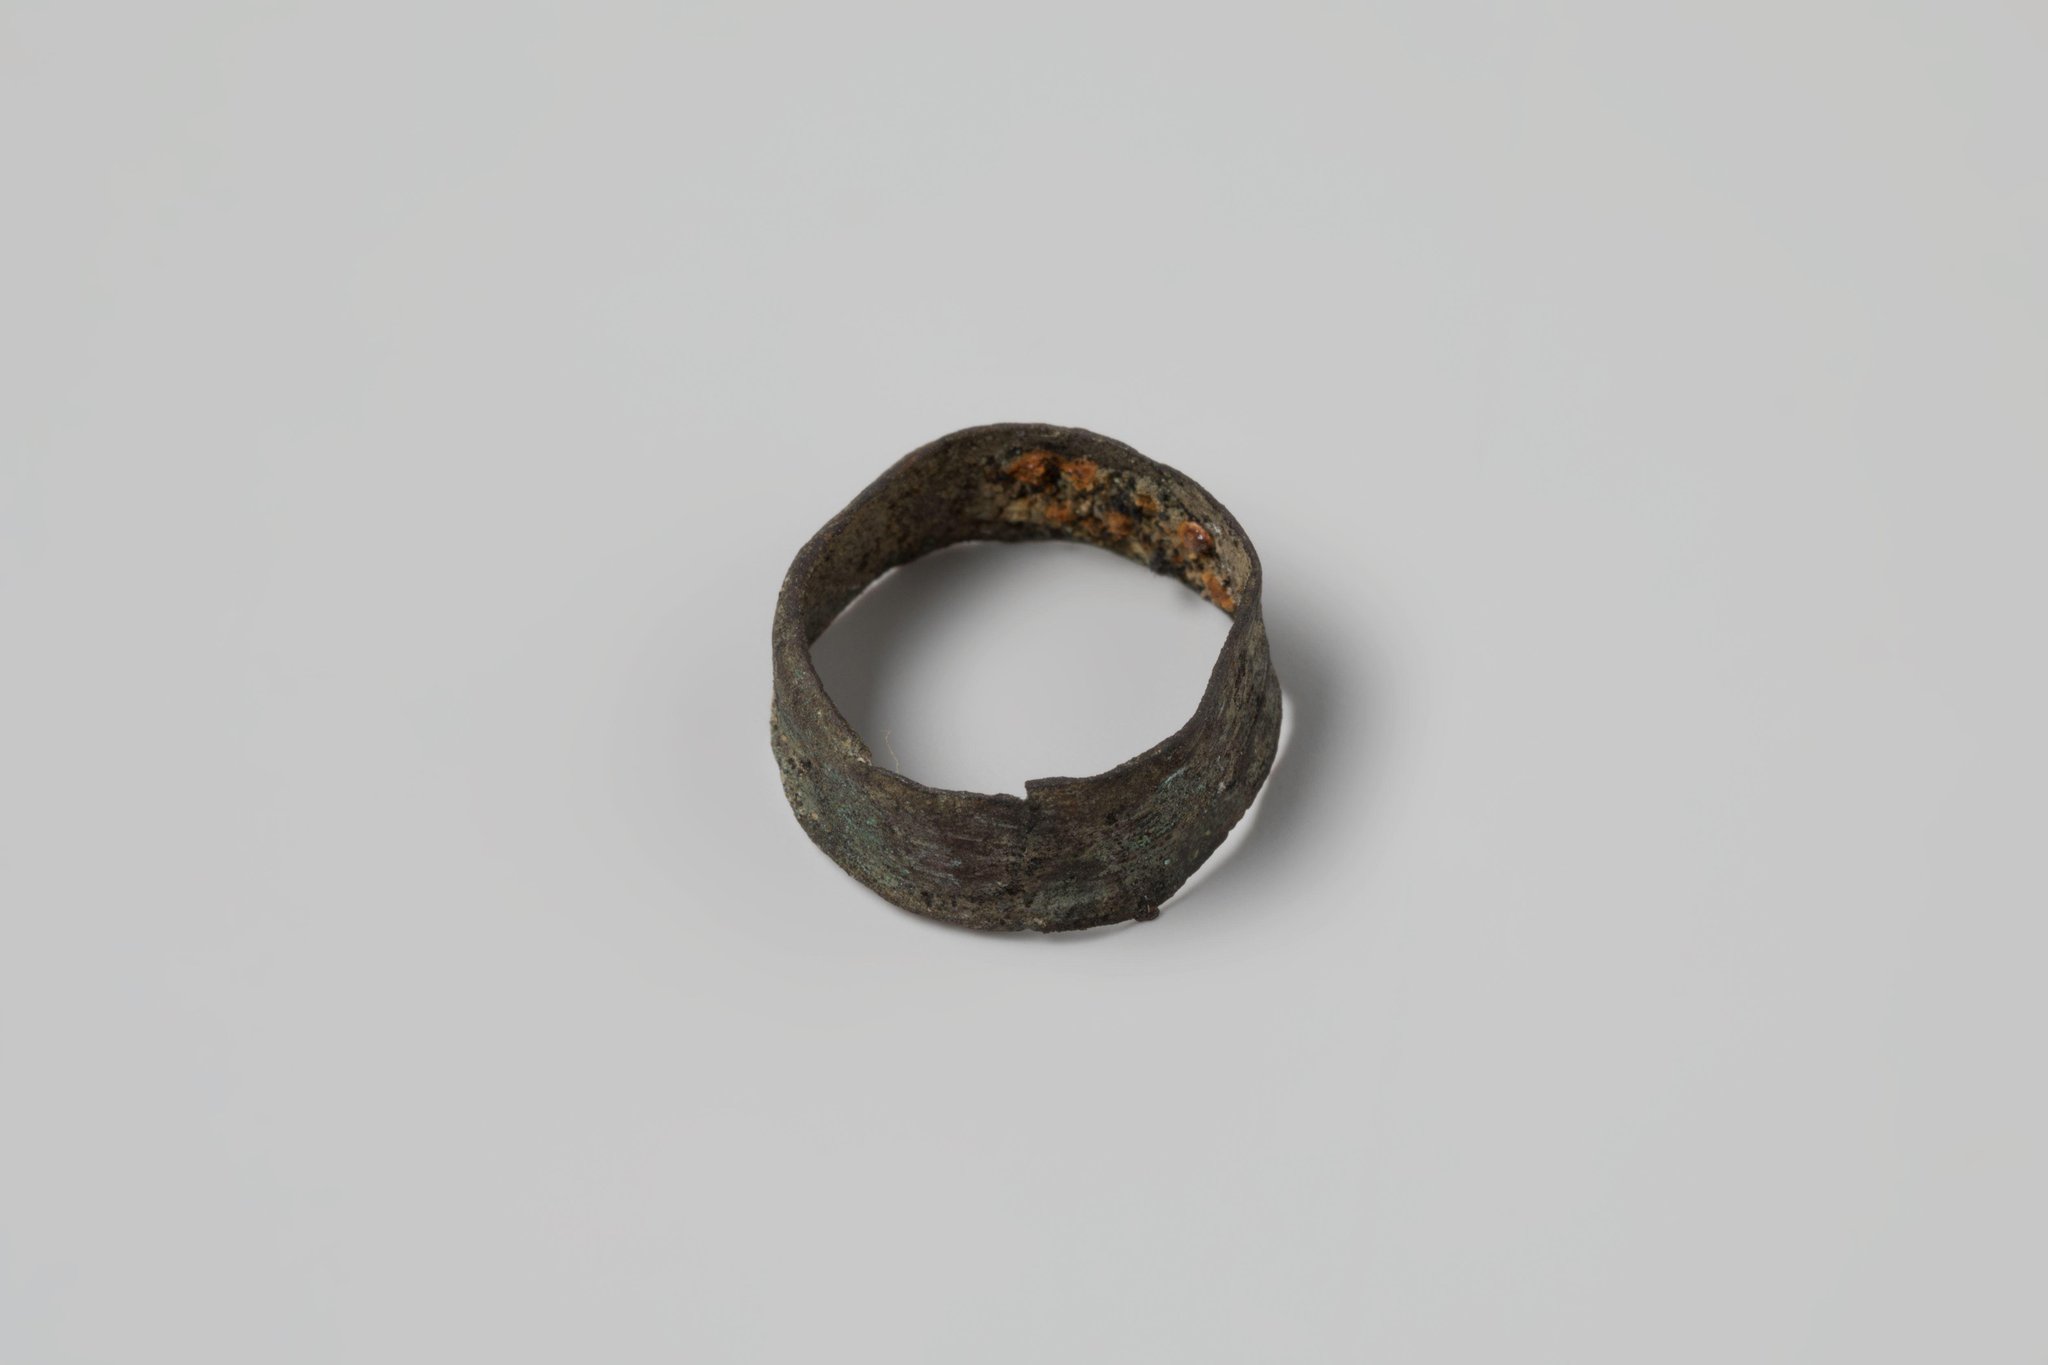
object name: ferrule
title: Messenheftring uit het wrak van de Oost-Indiëvaarder Hollandia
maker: Anonymous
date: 1700-1743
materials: copper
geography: netherlands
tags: verenigde oostindische compagnie, hollandia (schip), annet